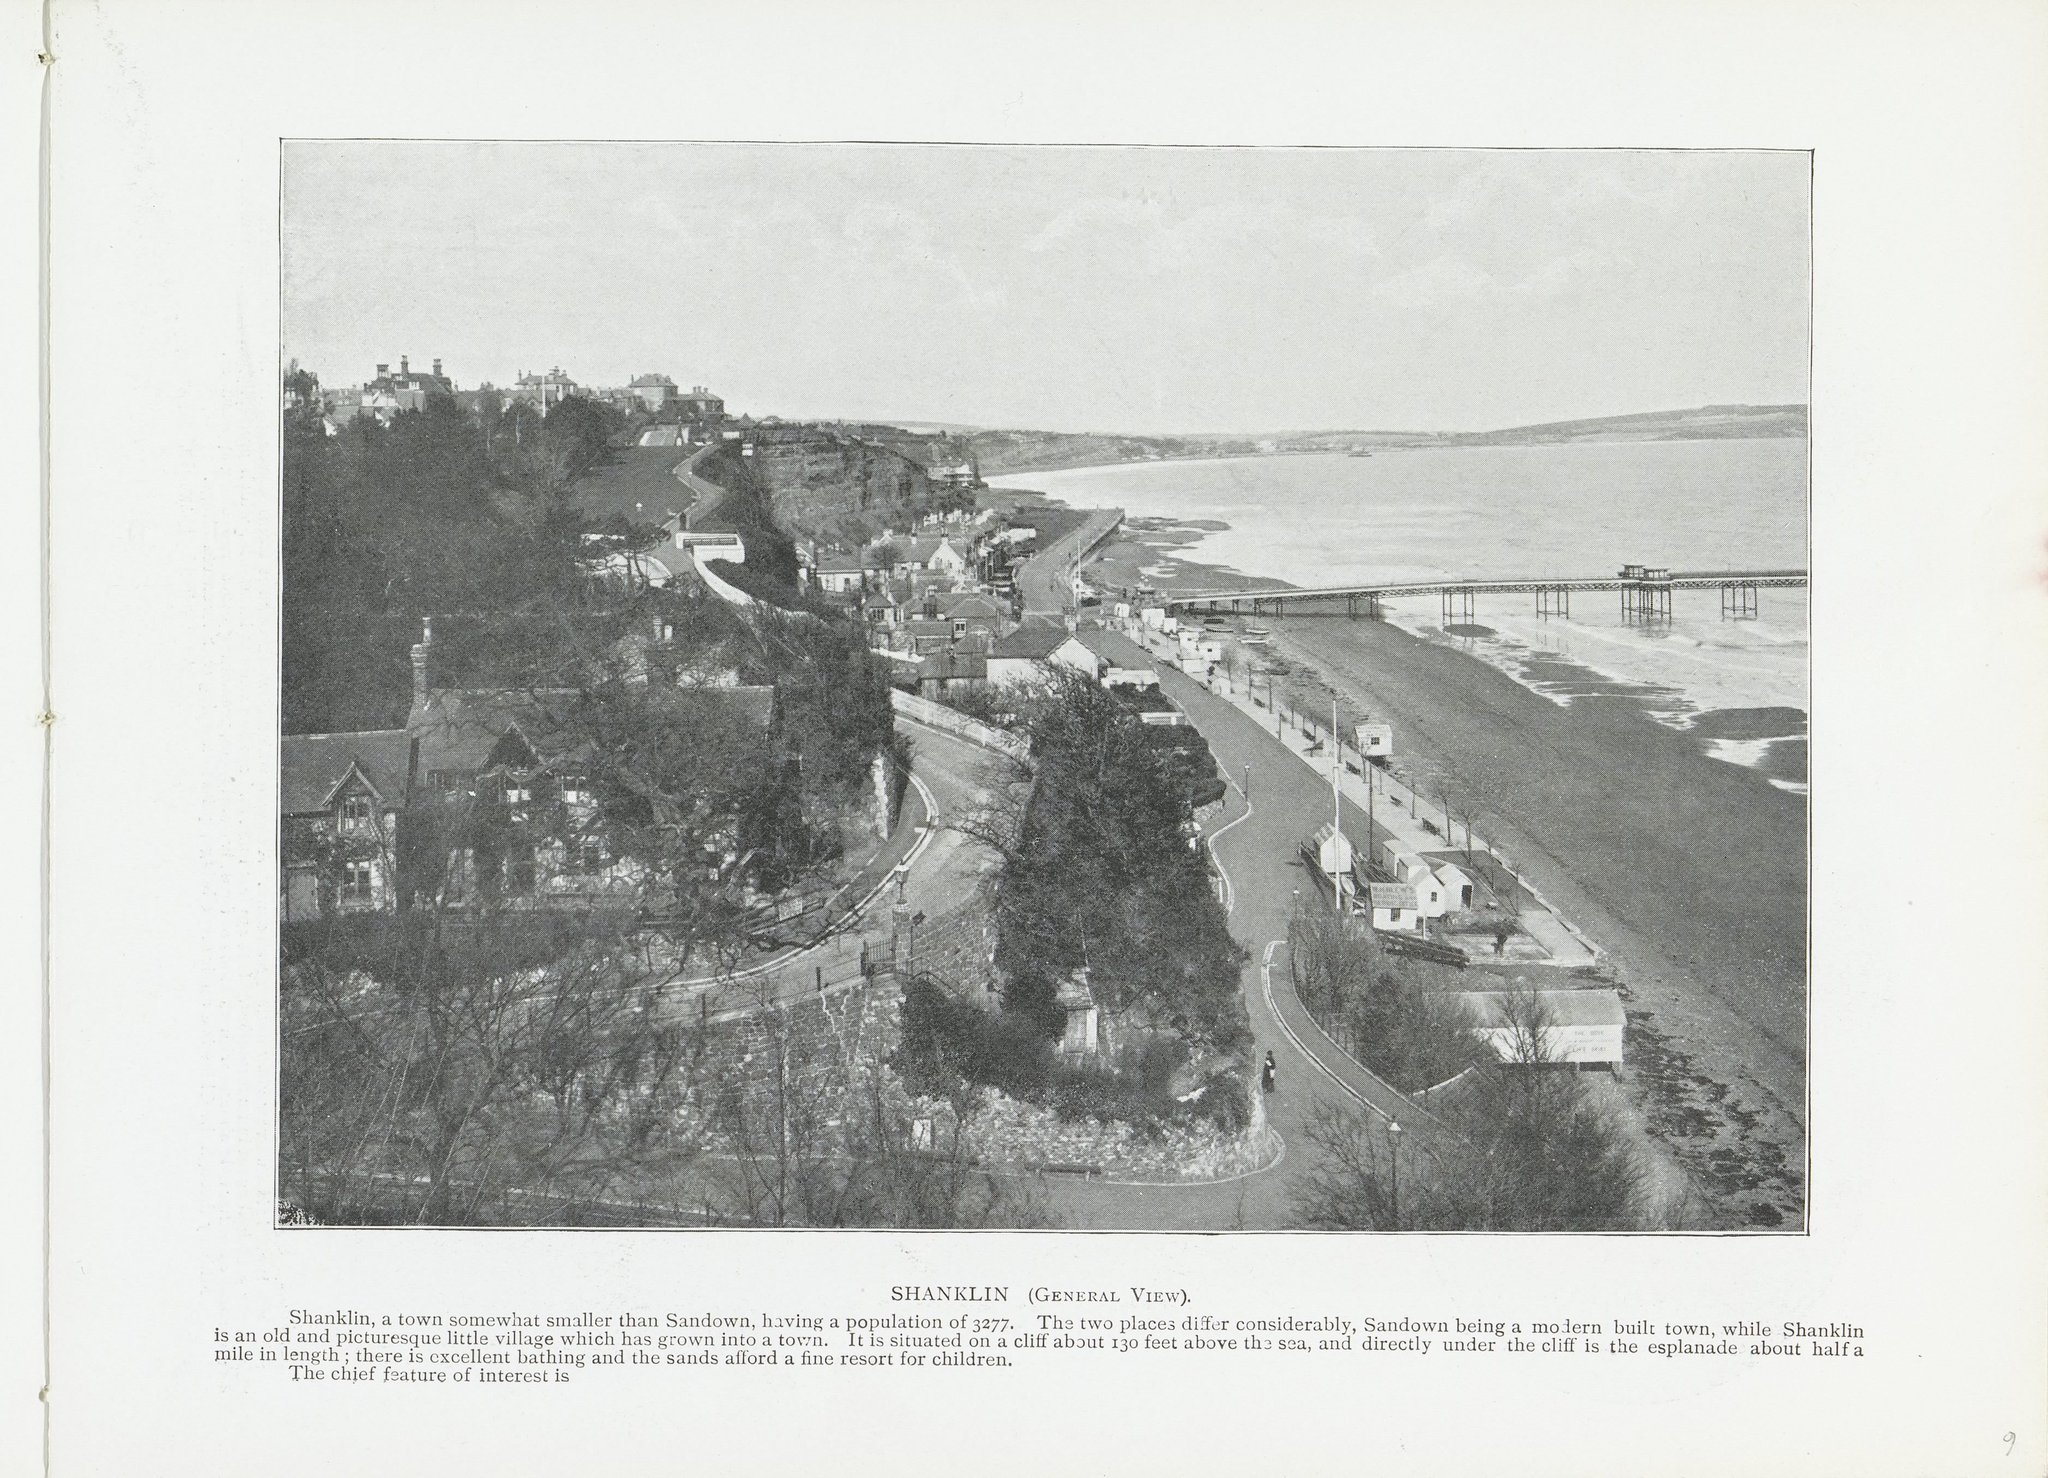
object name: page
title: Shanklin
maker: Anonymous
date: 1897-1930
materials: paper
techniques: printing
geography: isle of wight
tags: beach (as place of recreation), prospect of village, silhouette of village, avenue, boulevard, promenade, esplanade (+ city(-scape) with figures, staffage), travelling; tourism, isle of wight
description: Pagina 9 met een foto van het strand en de boulevard van Shanklin en een bijschrift. Onderdeel van Fotografische reisreportage van het eiland Wight.